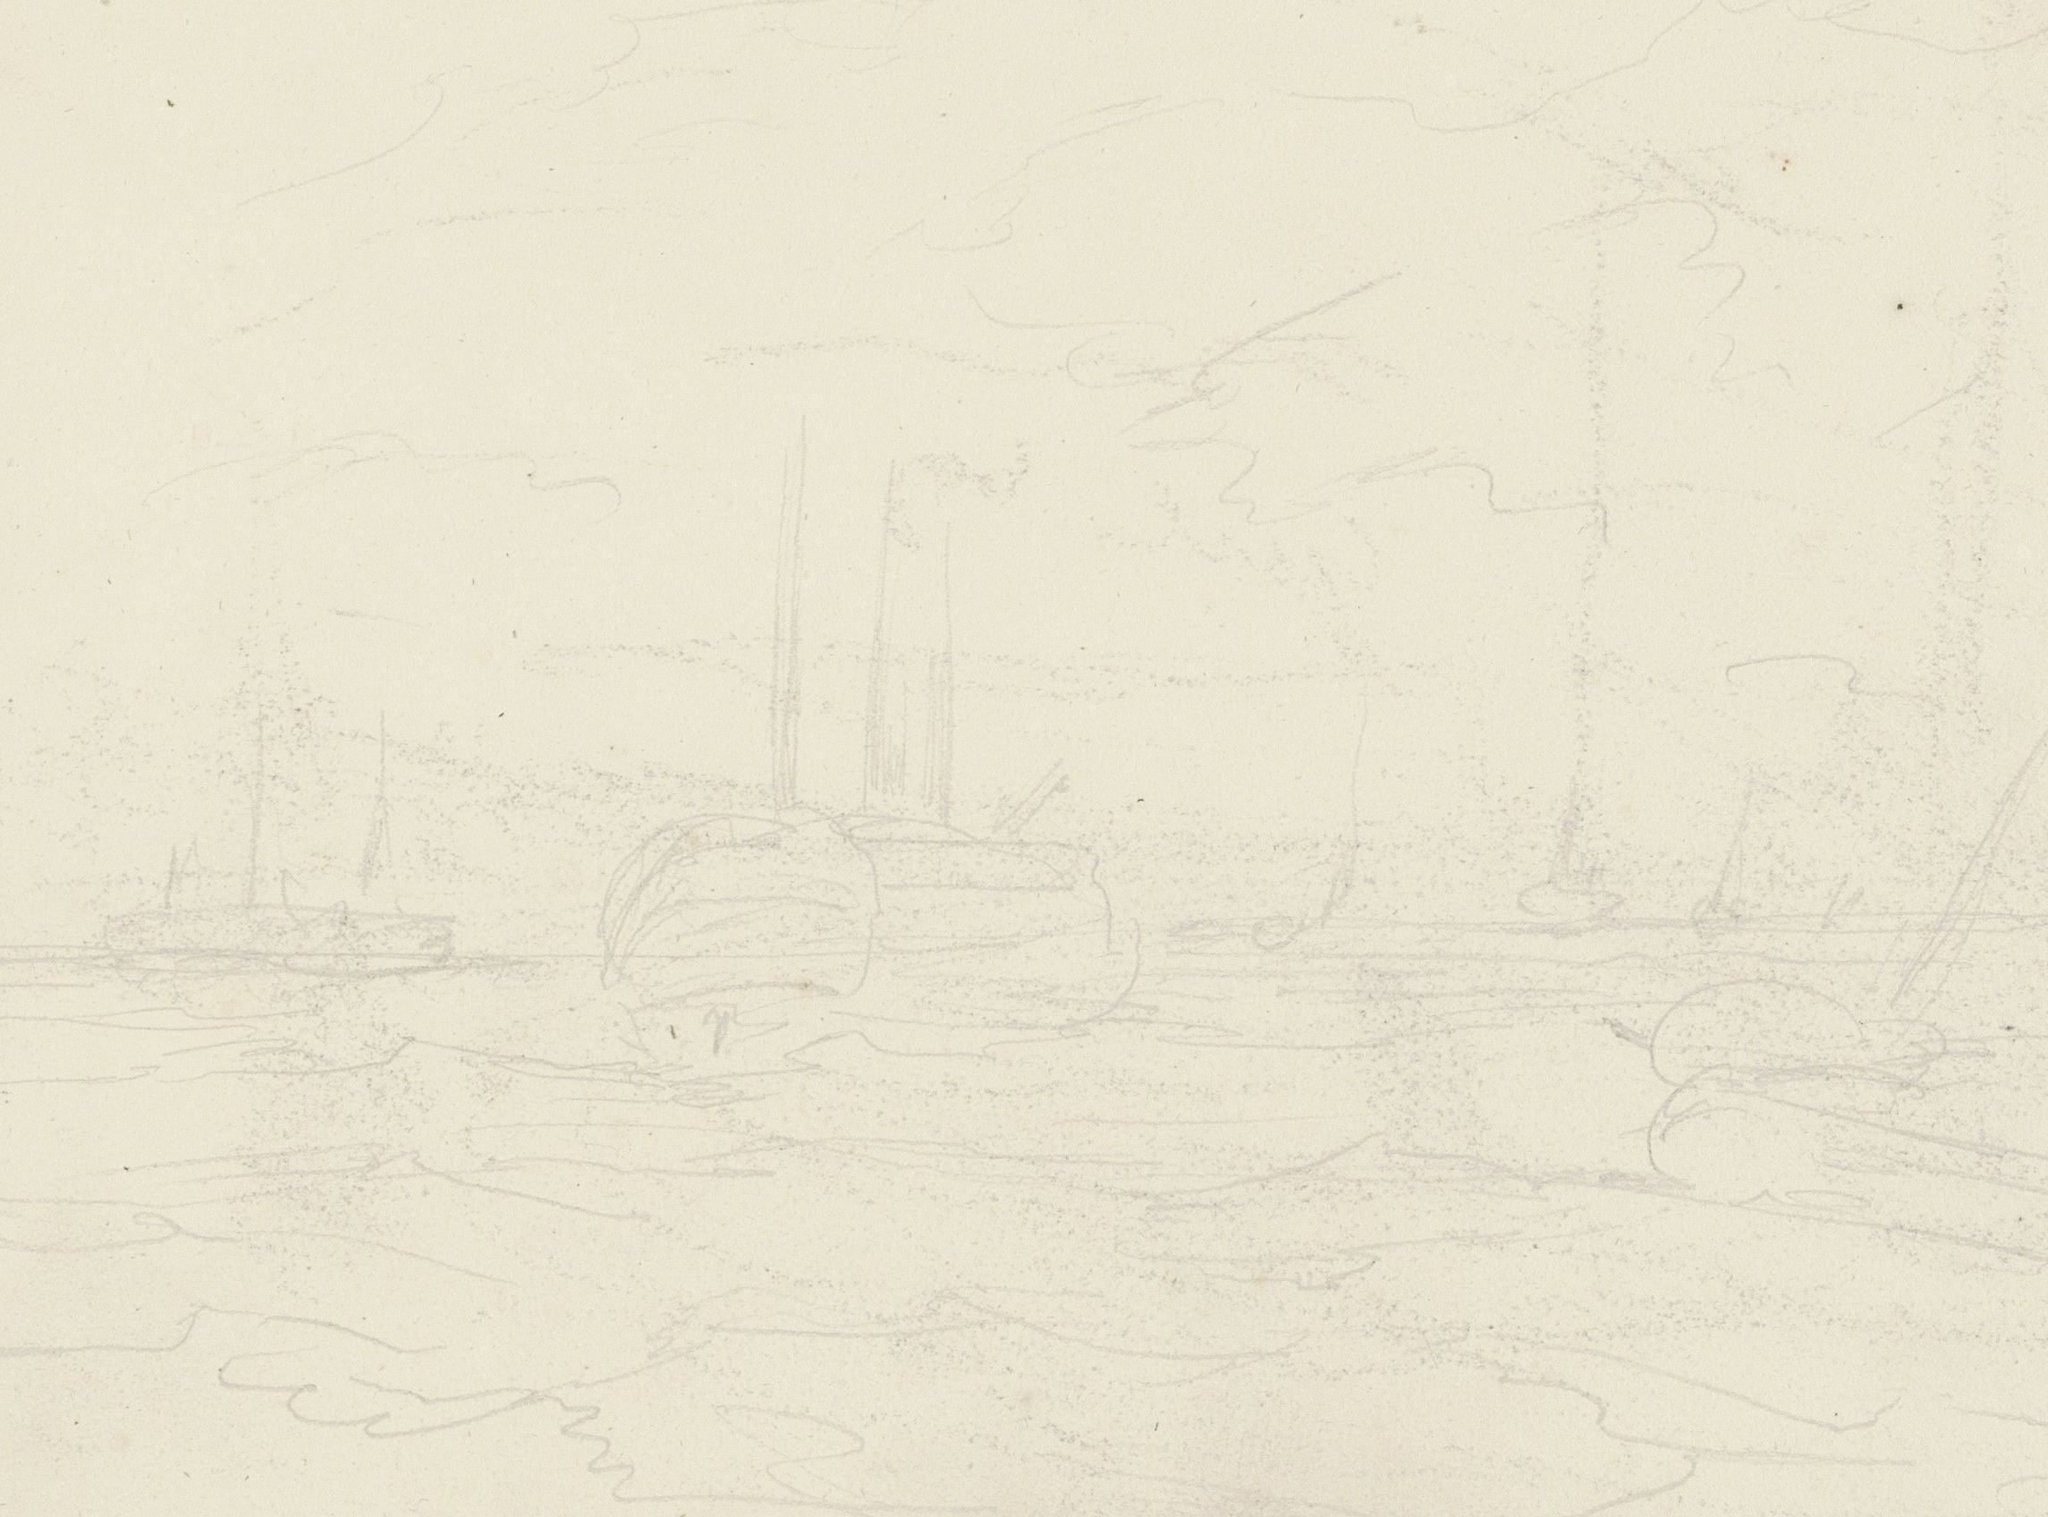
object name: sketchbook leaf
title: Zeegezicht met schepen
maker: petrus johannes schotel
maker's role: draughtsman, painter, print maker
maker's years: 1808-1865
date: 1825-1875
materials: paper, pencil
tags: sea (seascape)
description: Blad 28 recto uit een schetsboek met 44 bladen.